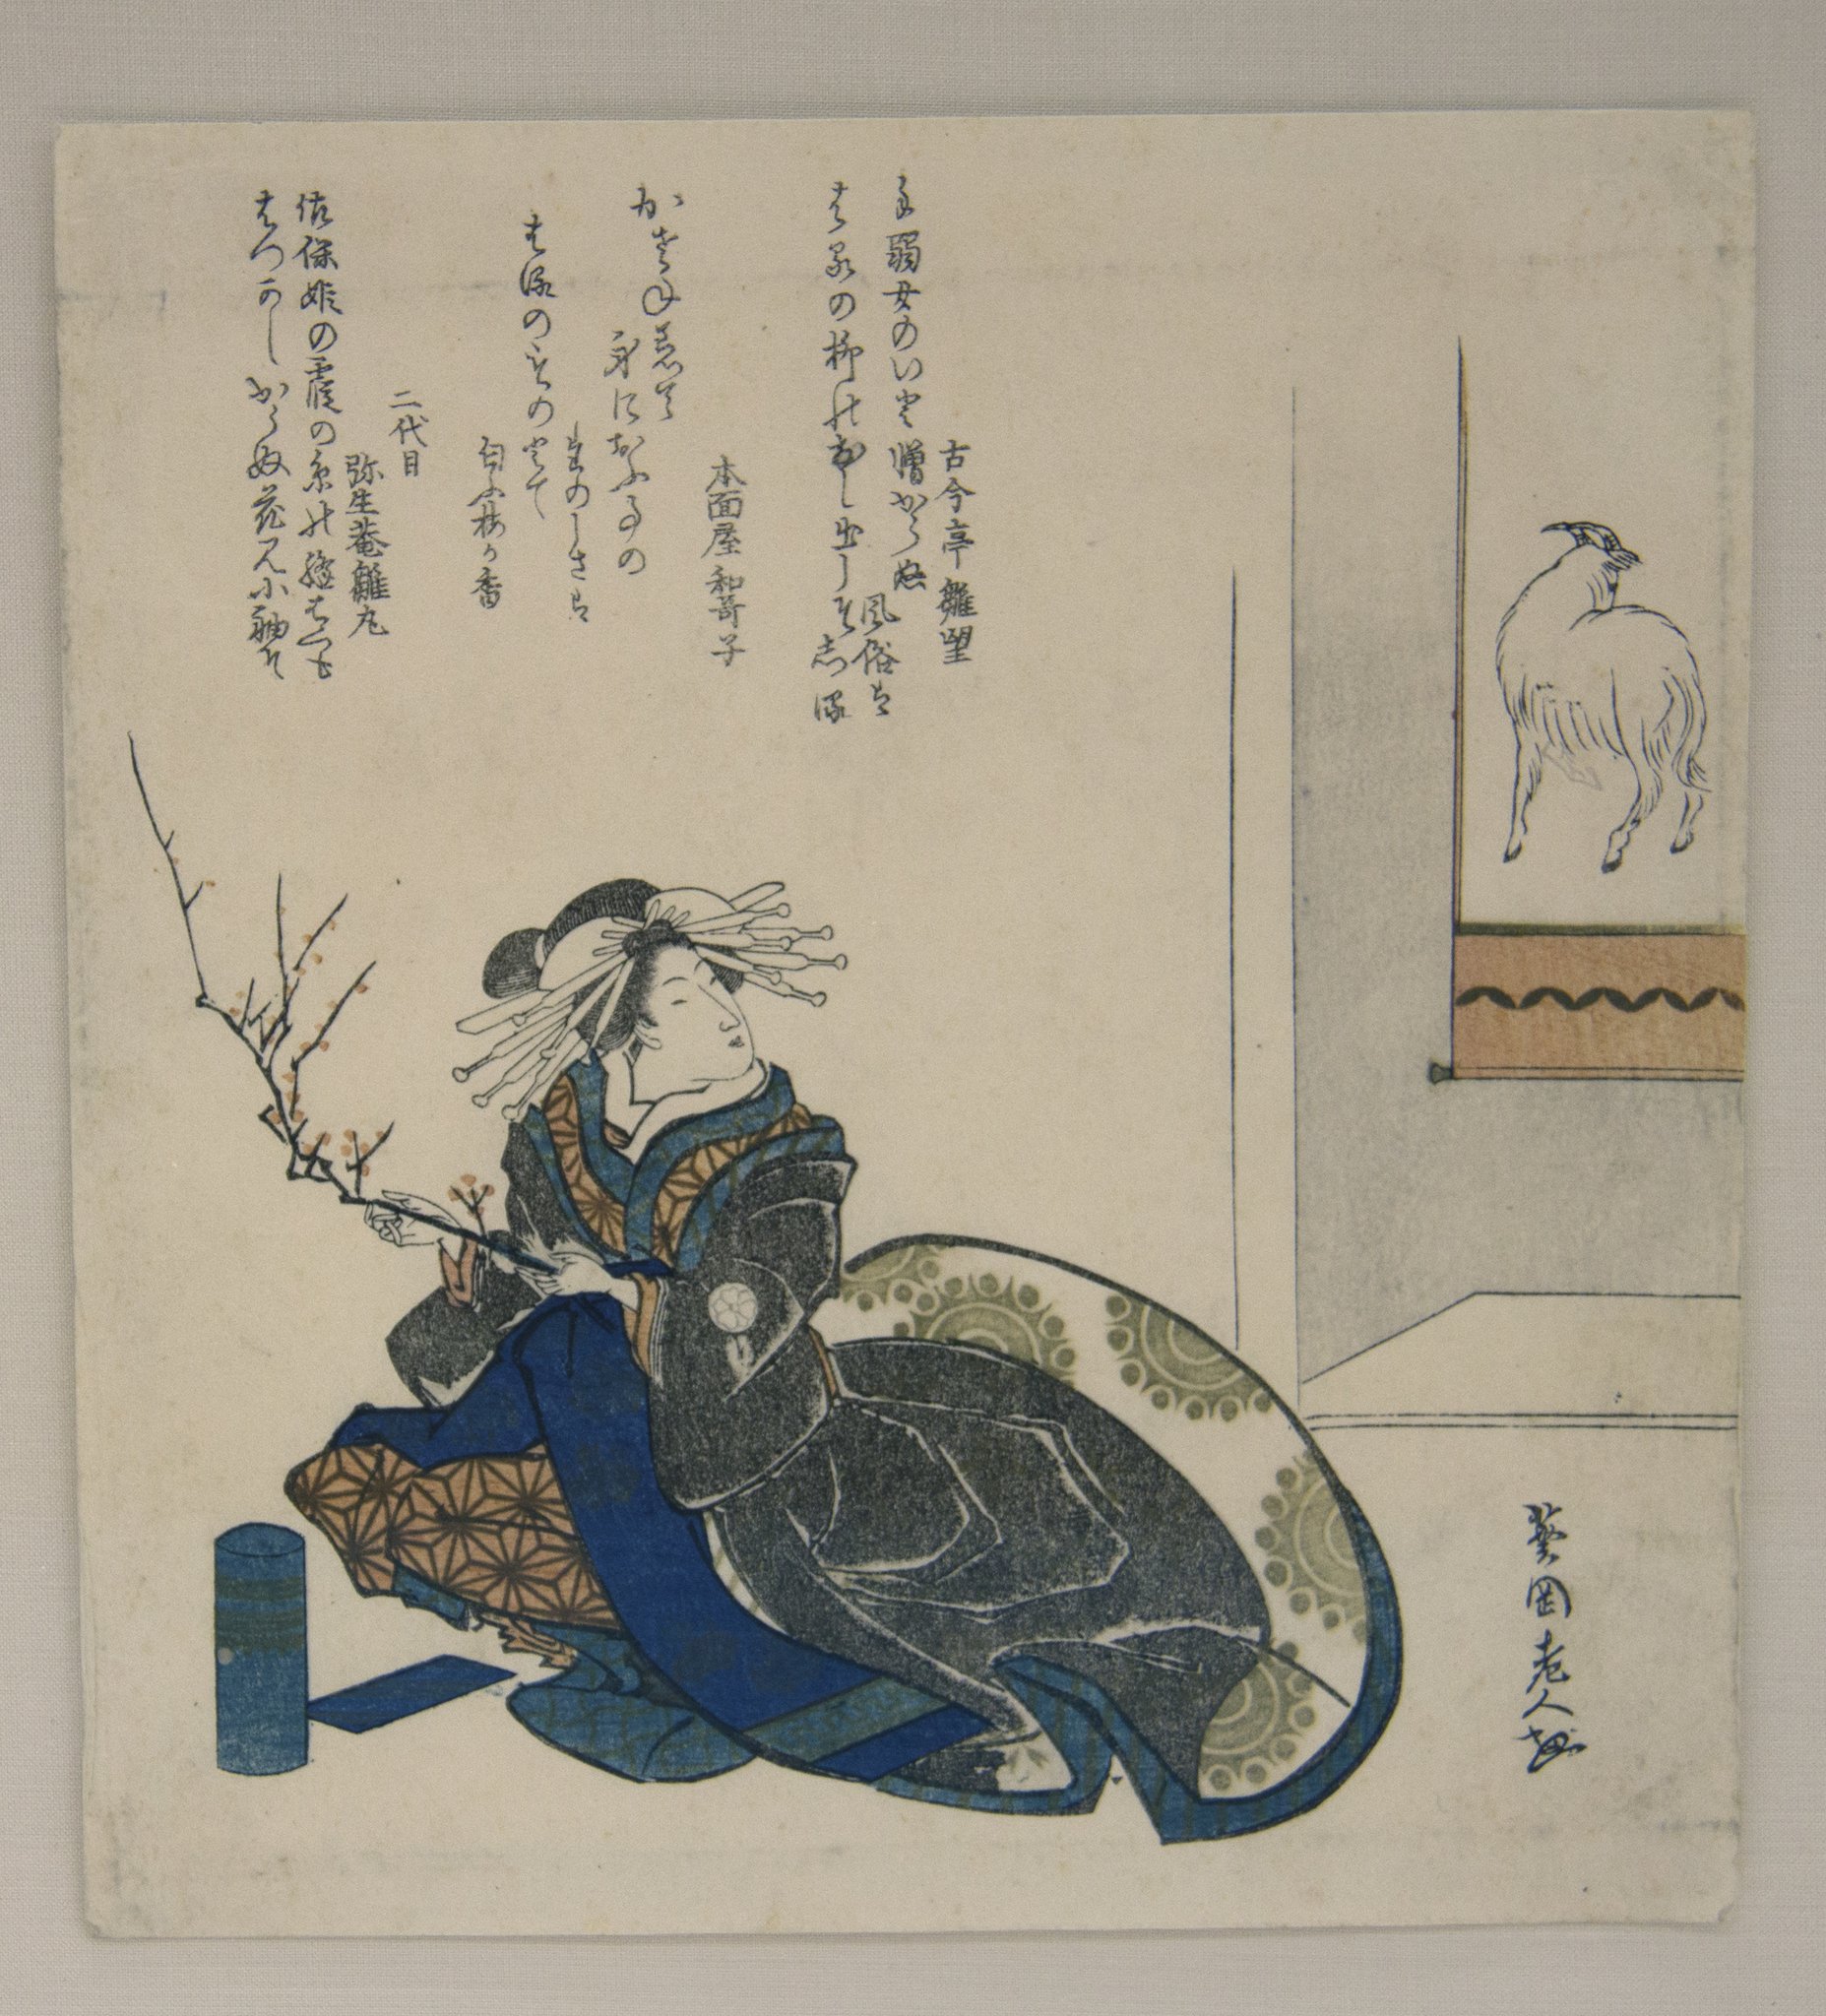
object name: woodblock print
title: Courtesan with Branch of Plum Blossoms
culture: japanese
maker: totoya hokkei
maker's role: artist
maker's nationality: japanese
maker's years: 1780-1850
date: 1835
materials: ink, paper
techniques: woodblock print, surimono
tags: animals,women,flowers